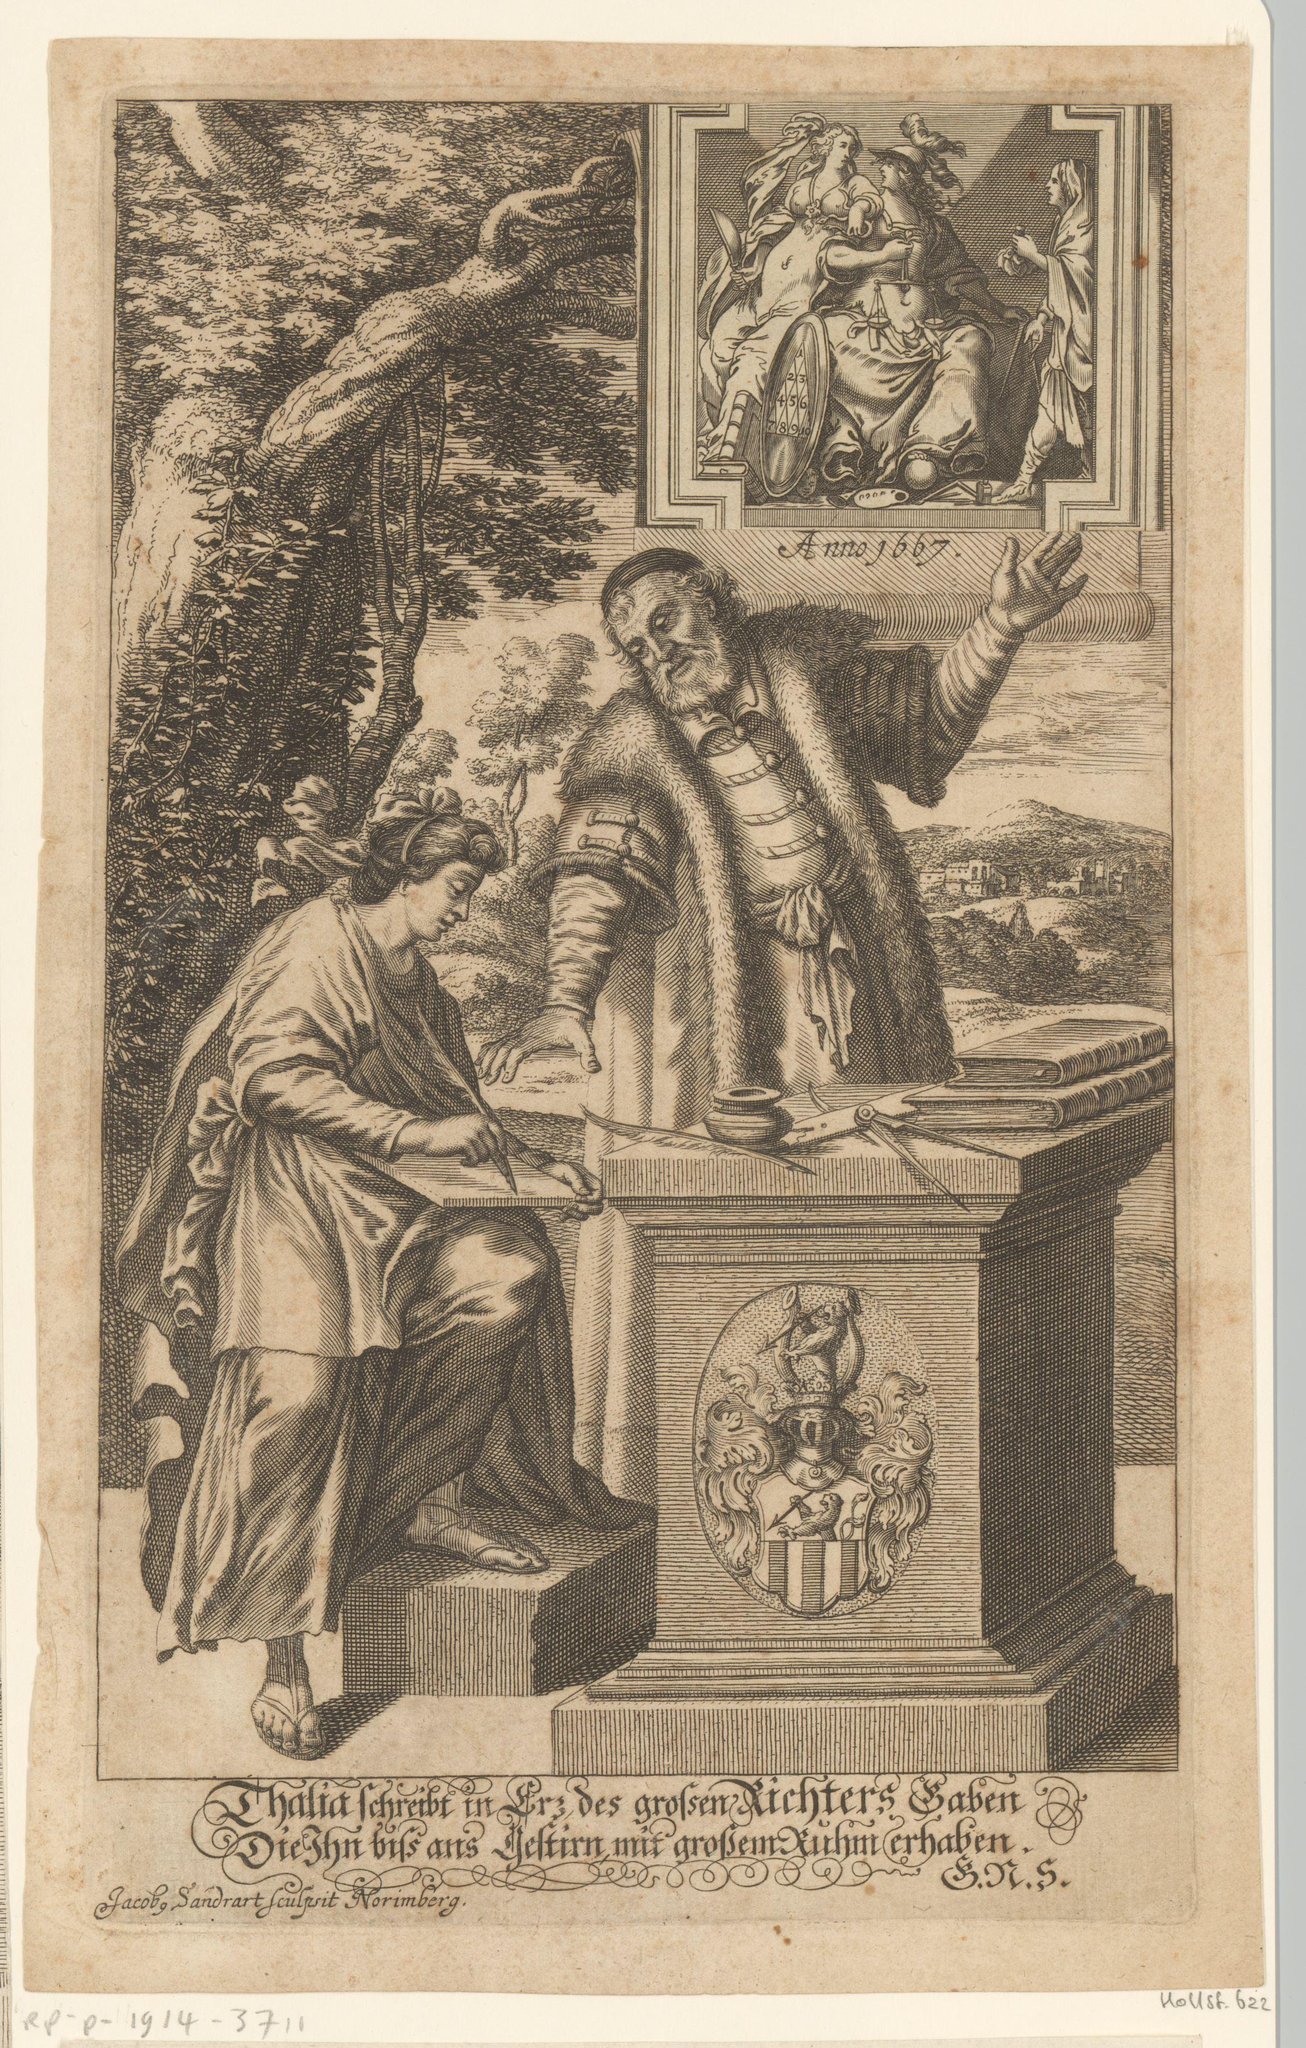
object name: print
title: Portret van Christoph Philipp Richter die aan Thalia dicteert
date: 1667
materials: paper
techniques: engraving, etching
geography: nuremberg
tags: landscapes, historical persons, writing accessories, thalia (one of the muses); 'talia' (ripa), armorial bearing, heraldry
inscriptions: collector's mark: Lugt 2228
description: Prent ook gebruikt als titelpagina voor: Richter, C.P. Volumen Velitationum Academicarum. Jena: S. Krebs, 1667.